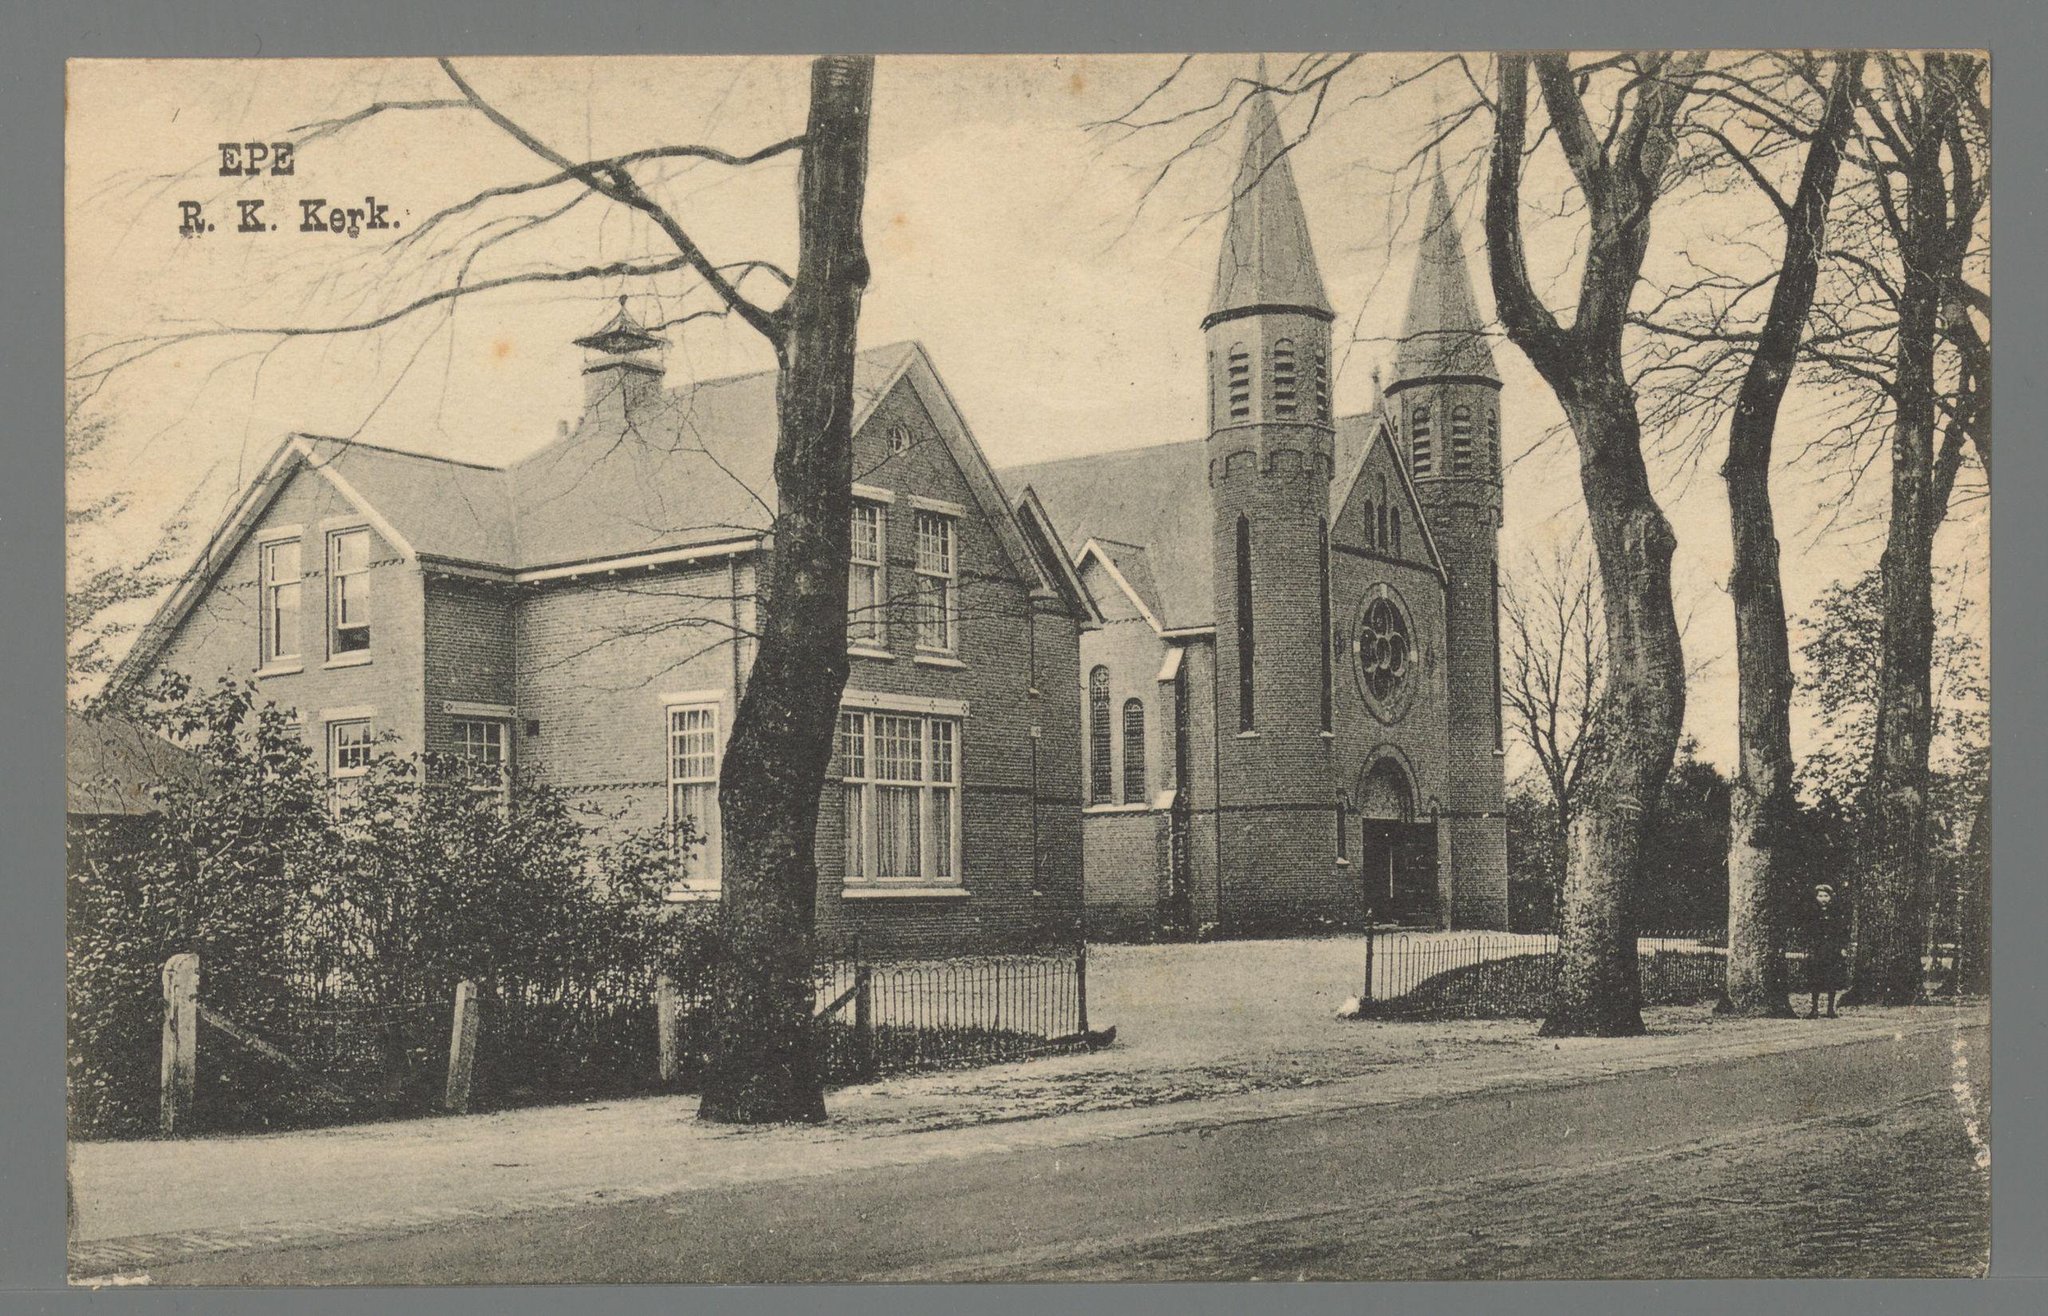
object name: photomechanical print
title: Epe. R. K. Kerk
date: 1905-1927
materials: cardboard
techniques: photograph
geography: epe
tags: church (exterior)